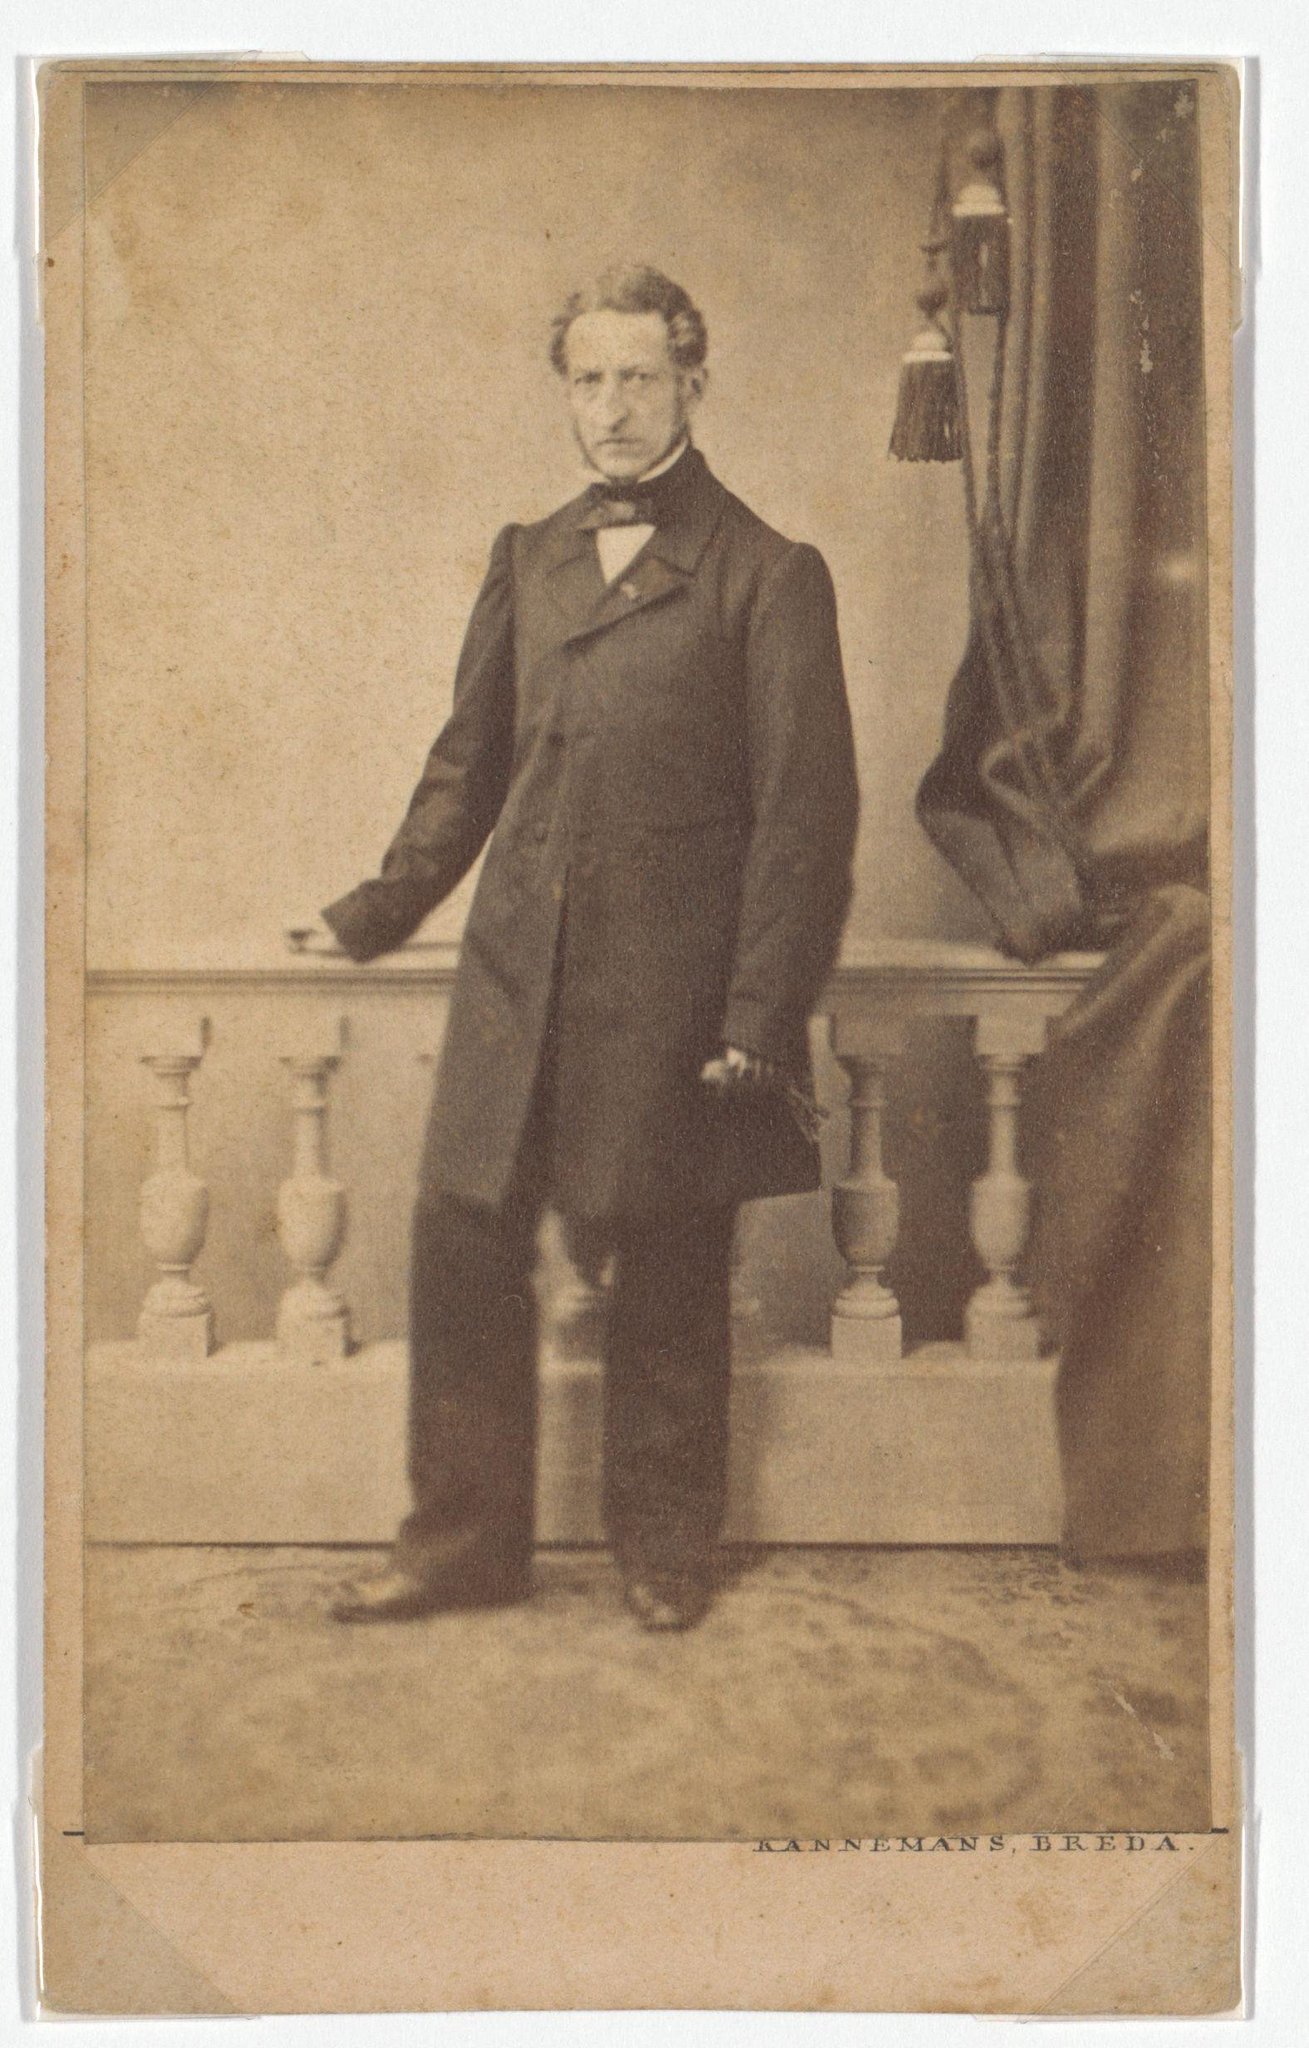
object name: photograph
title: Portret van professor A.A. van Heusden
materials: cardboard, paper, photographic support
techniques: albumen print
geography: breda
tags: studio requisites ~ photographer, historical persons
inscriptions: inscription: ‘Professor Dr. A.A. Van Heusden geb. 25 februari 1808 overleden 16 April 1874’